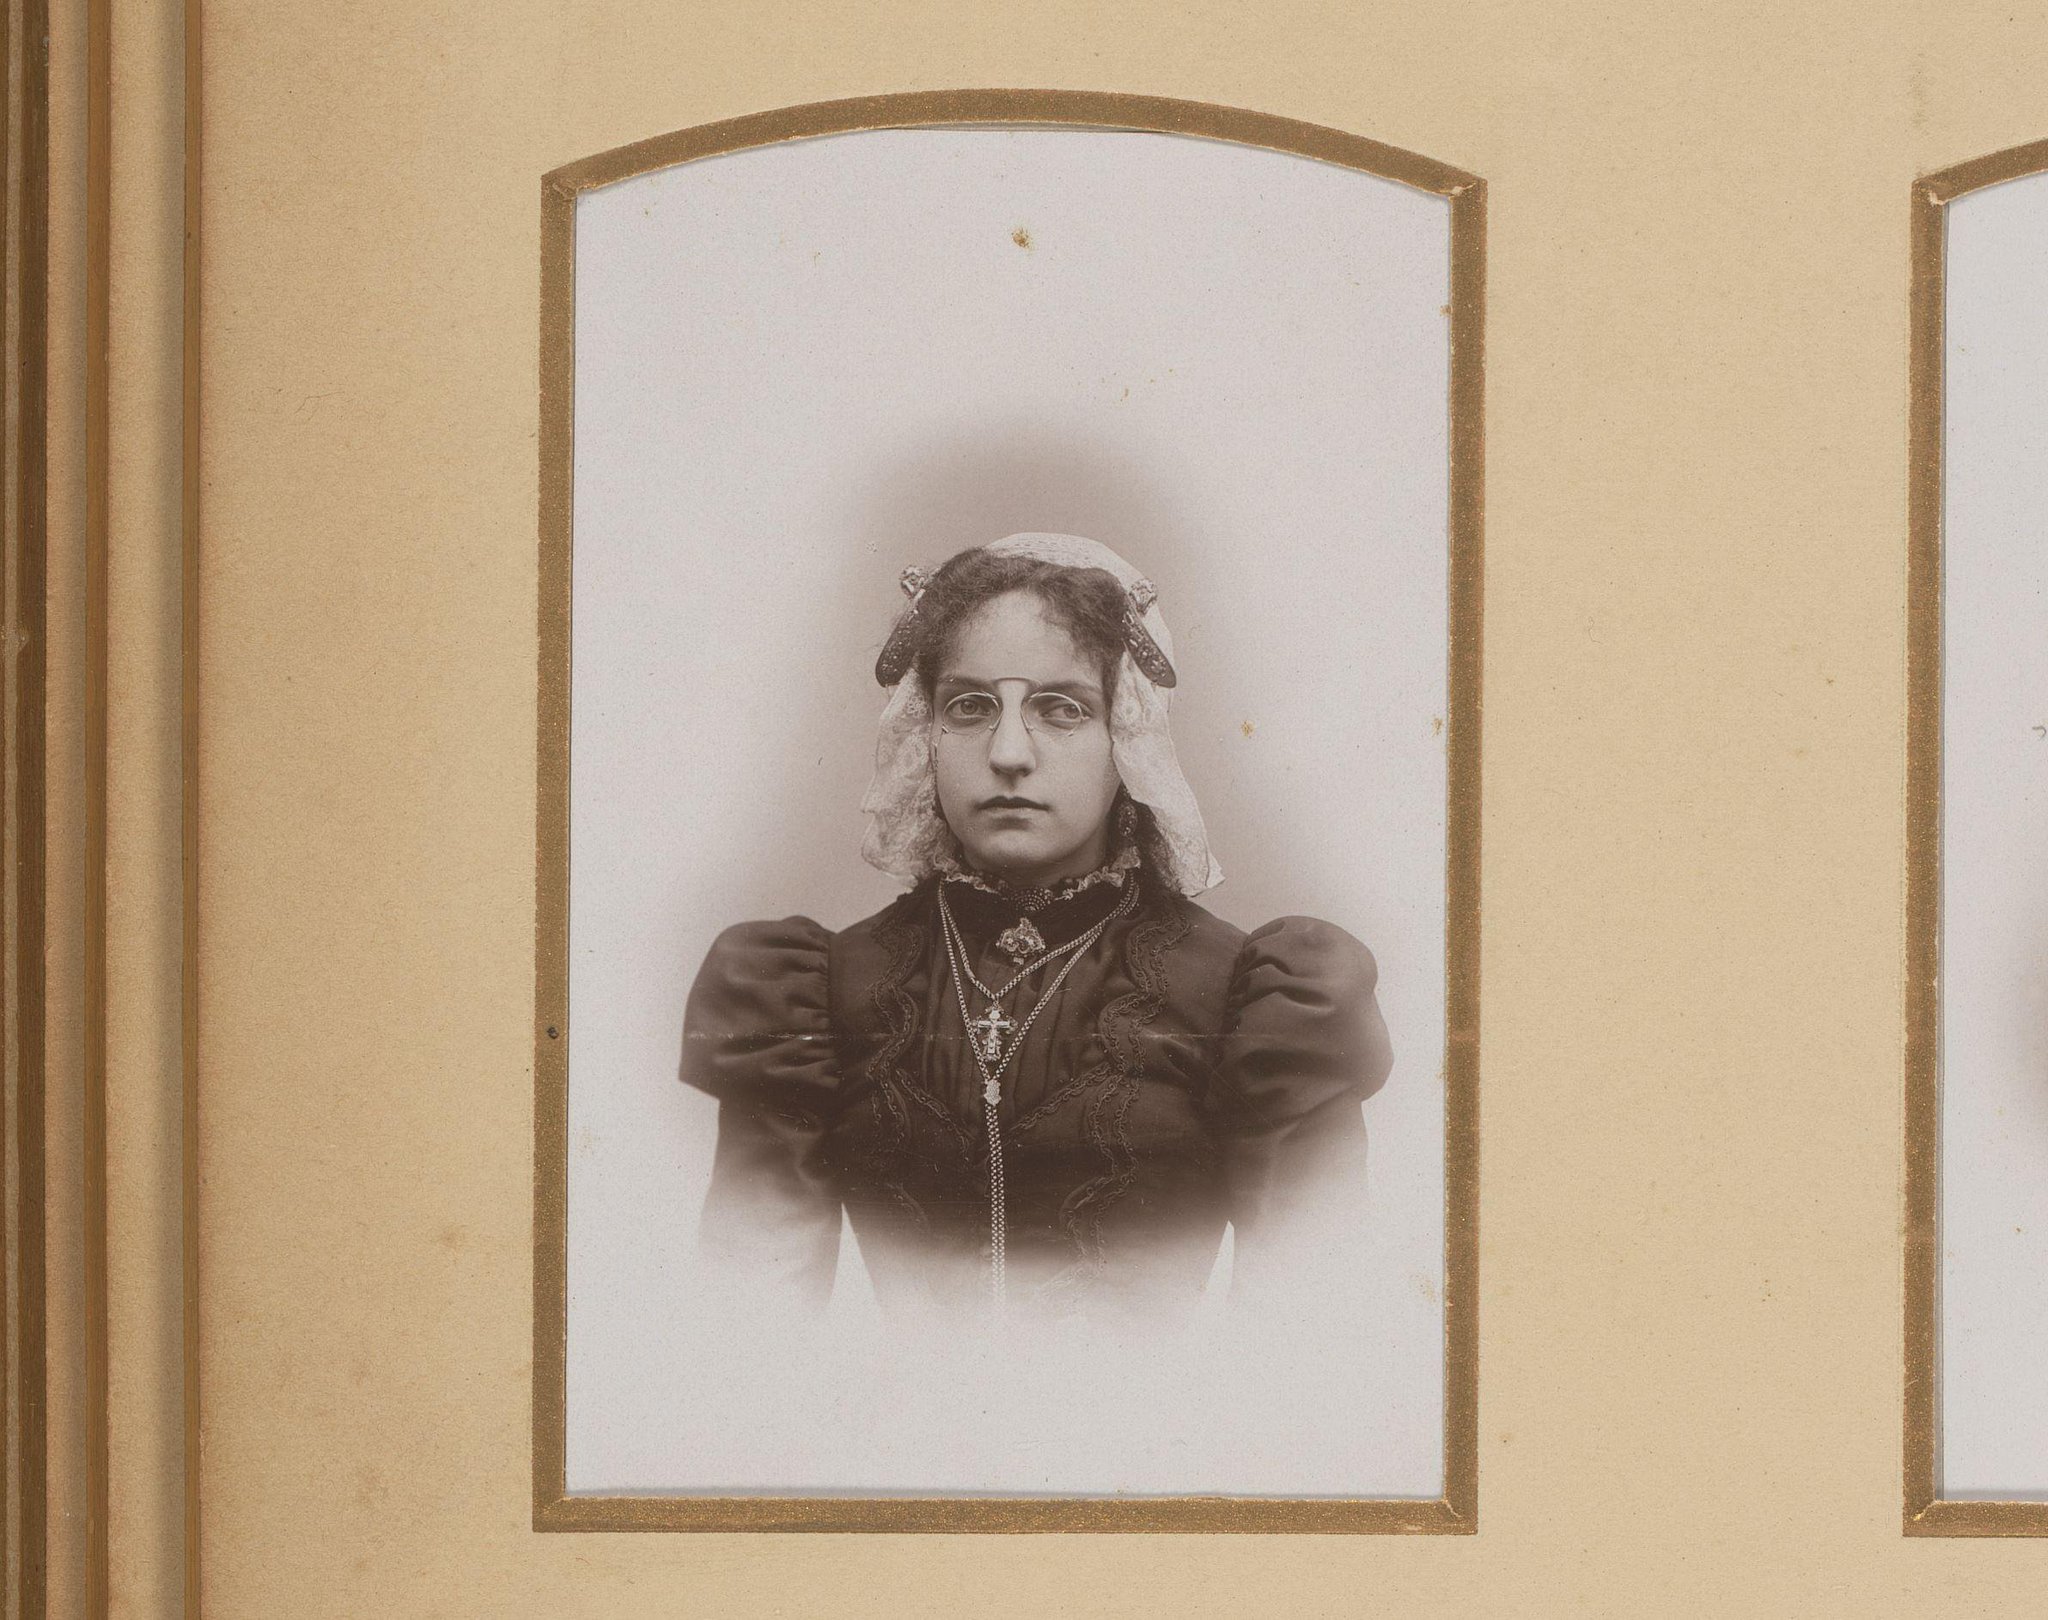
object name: album leaf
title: Portret van een jonge vrouw met witte klederdrachtmuts en bril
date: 1890-1918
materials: cardboard, photographic support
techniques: collodion silver print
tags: eyeglasses, spectacles, adolescent, young woman, maiden, historical persons - bb - woman, head-gear: cap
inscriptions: inscription: ‘Photographische/ Ateliers/ J. Siewers & Zoon/ Edam/ Hilversum./ Specialiteit in vergrootingen.’